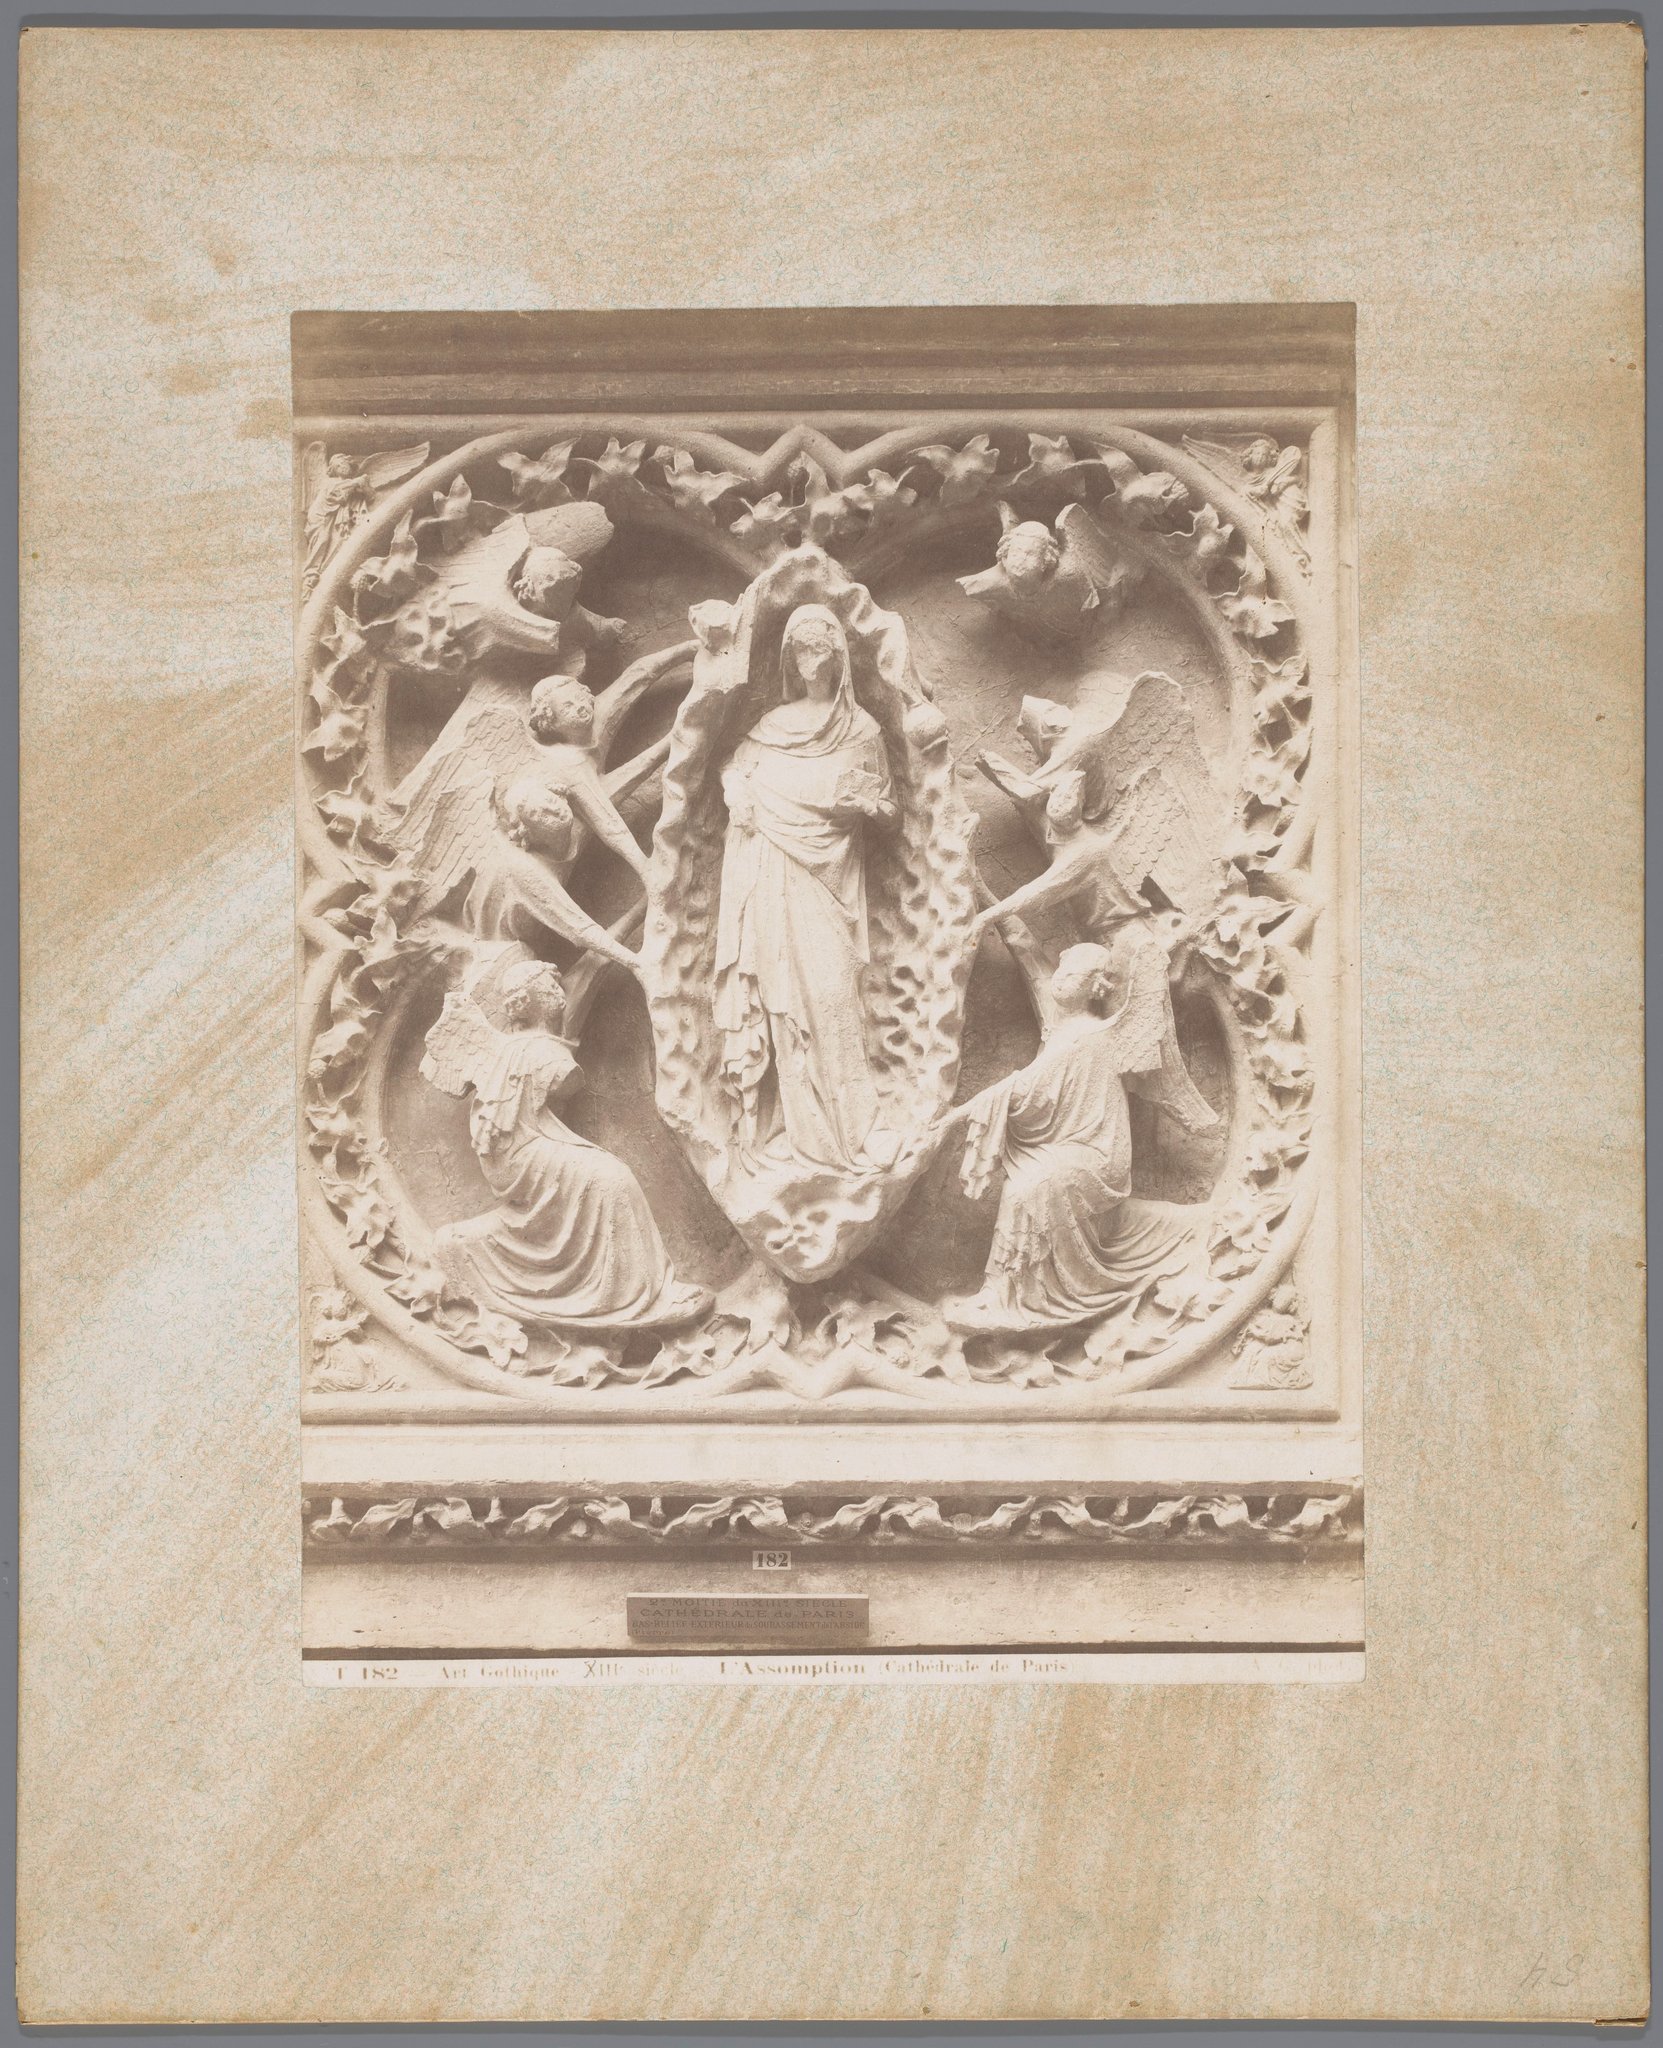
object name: photograph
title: L'Assomption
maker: Anonymous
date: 1850-1900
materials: cardboard, photographic support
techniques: albumen print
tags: the assumption of mary ('assumptio corporis'): she is borne into heaven by angels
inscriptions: number: ‘T 182’, inscription: ‘(Cathédrale de Prais) A.G. phot.’, collector's mark: ‘Rijks-normaalschool voor teekenonderwijzers amsterdam’